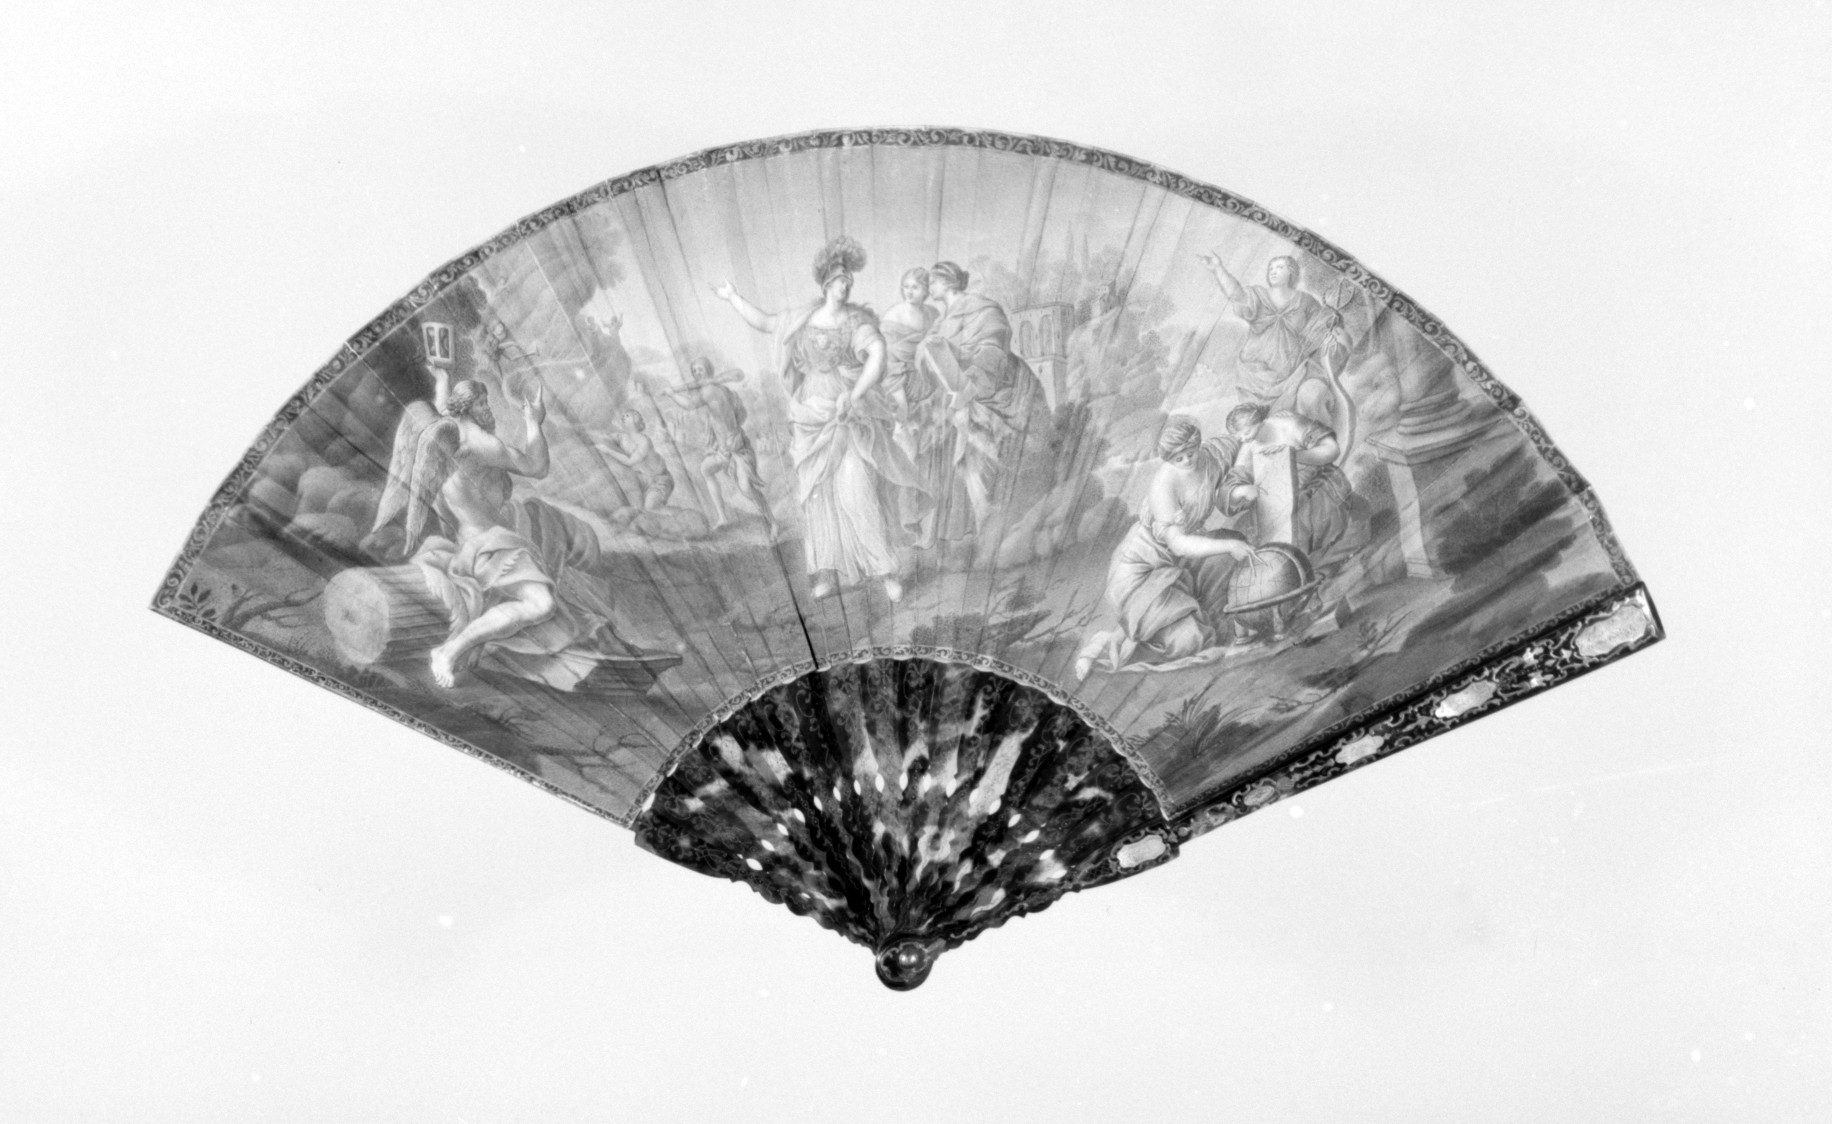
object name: fan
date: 1701-1733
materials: gold, mother of pearl, parchment, shell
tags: men,women